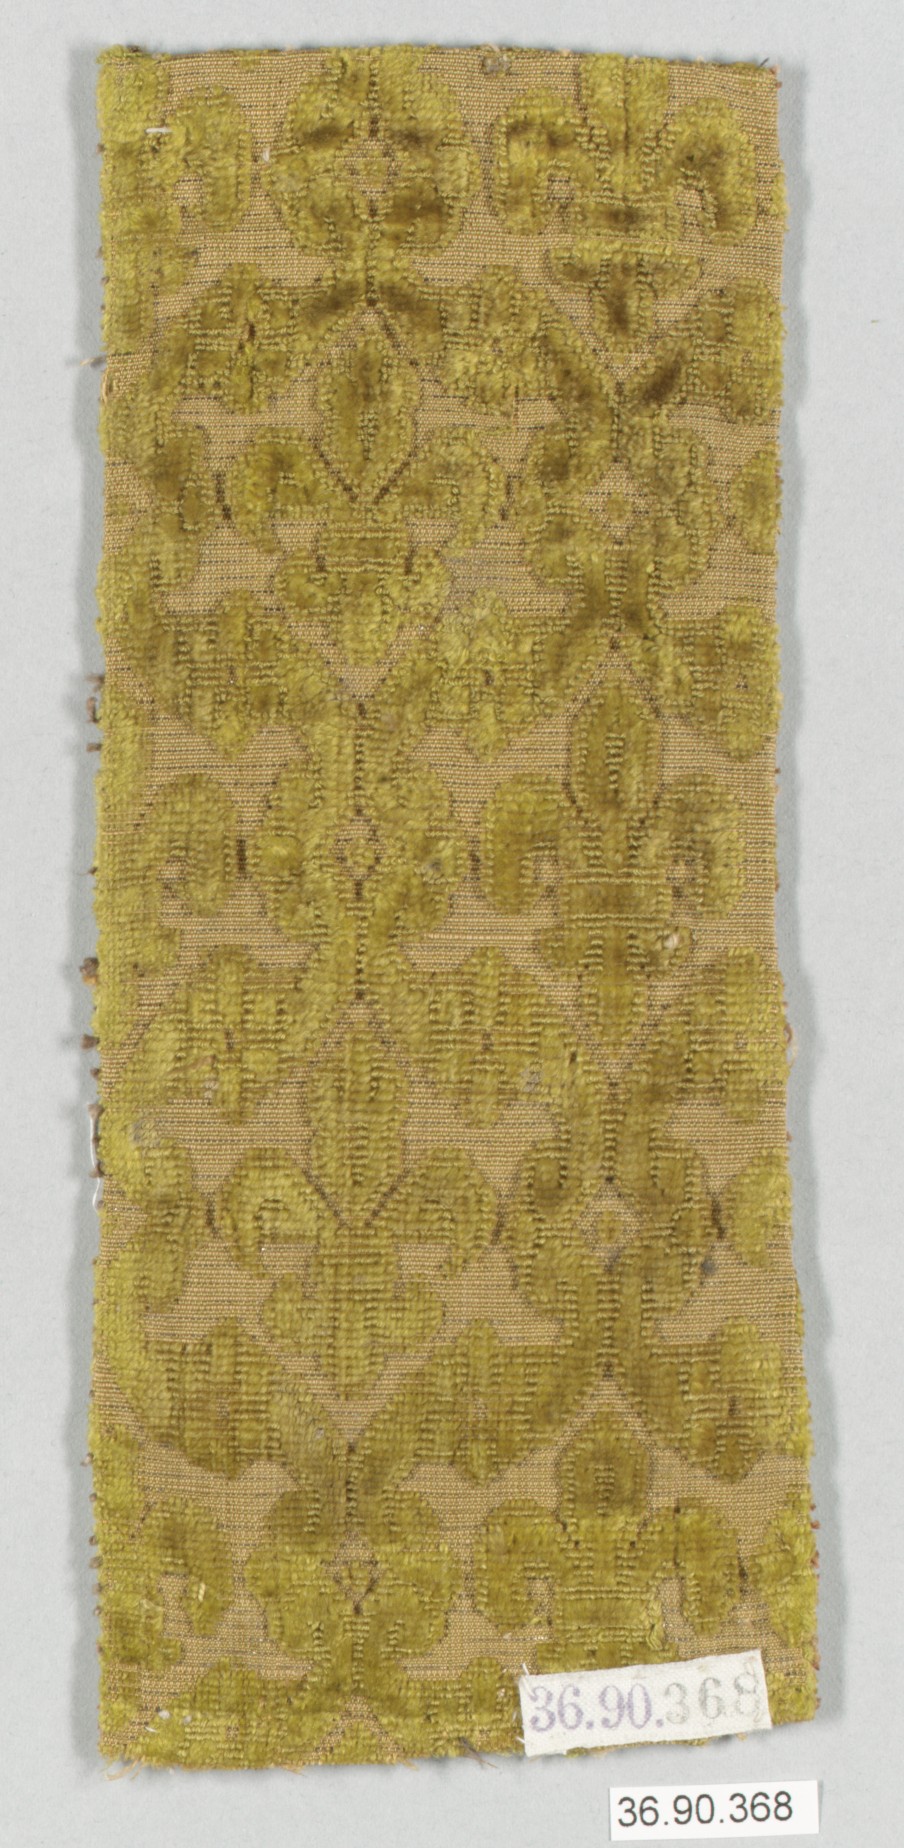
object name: piece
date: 1501-1700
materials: metal thread, silk